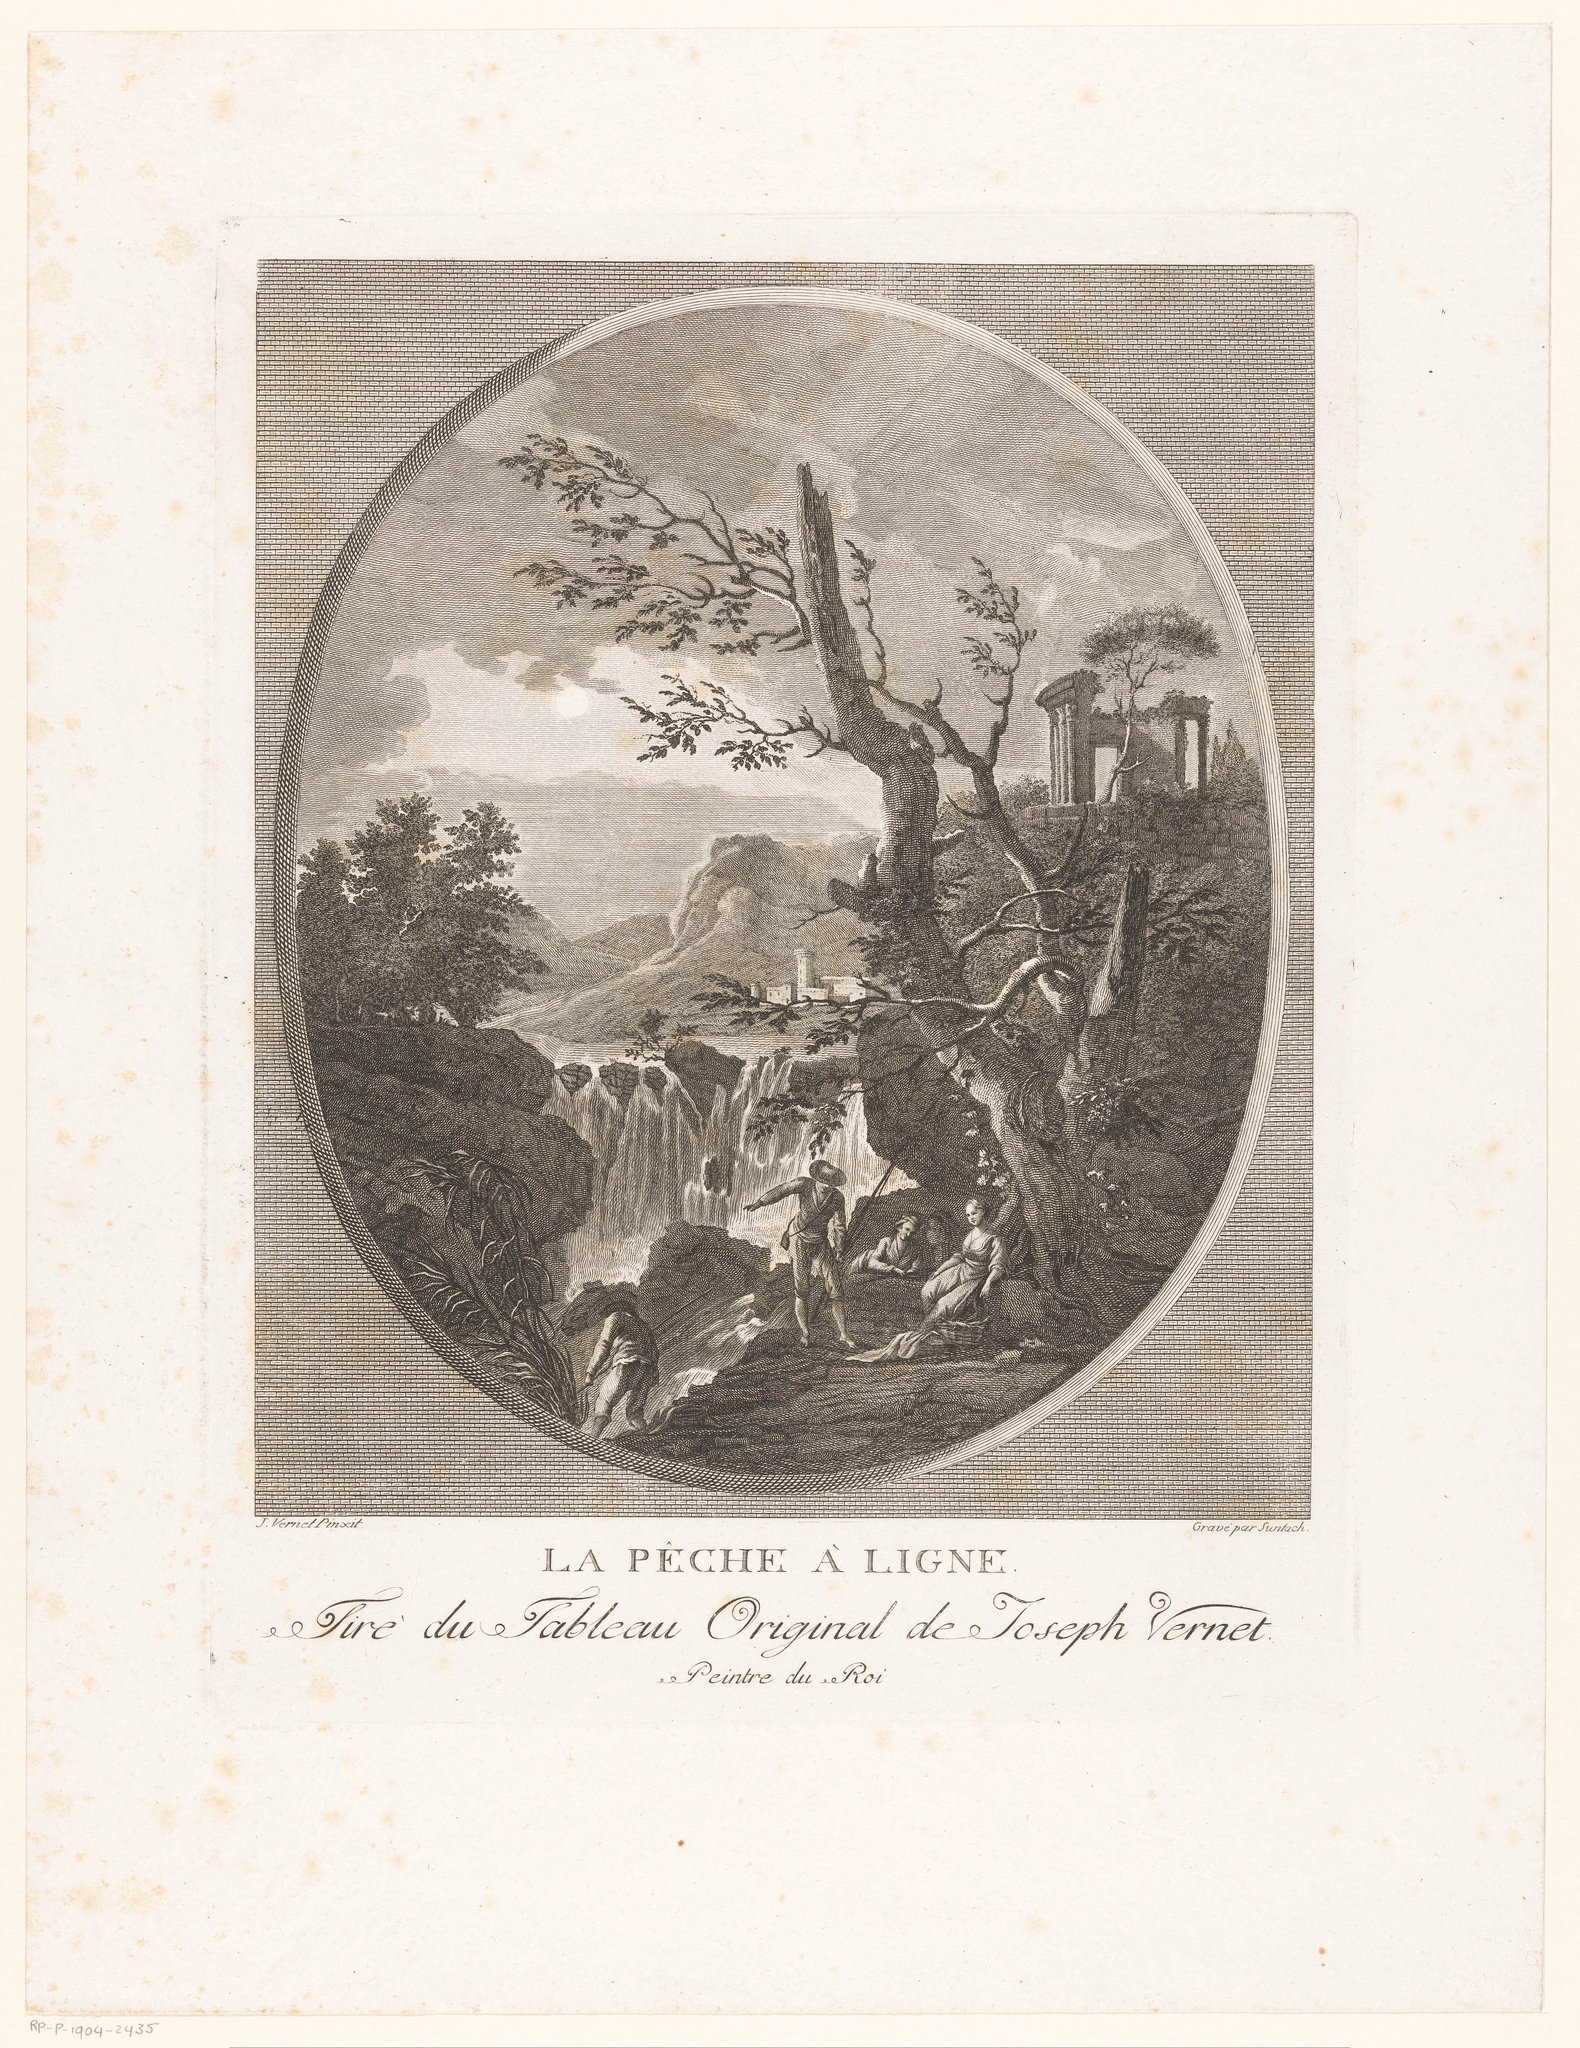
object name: print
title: Landschap met waterval en een ruïne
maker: claude joseph vernet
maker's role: draughtsman, painter, print maker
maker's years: 1714-1789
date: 1754-1842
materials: paper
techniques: engraving, etching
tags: city-view, and landscape with man-made constructions, waterfall, landscape with ruins, fisherman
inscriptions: collector's mark: Lugt 2228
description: Een landschap met een waterval en op de voorgrond figuren die aan het vissen zijn. Rechts een ruïne van een ronde tempel.